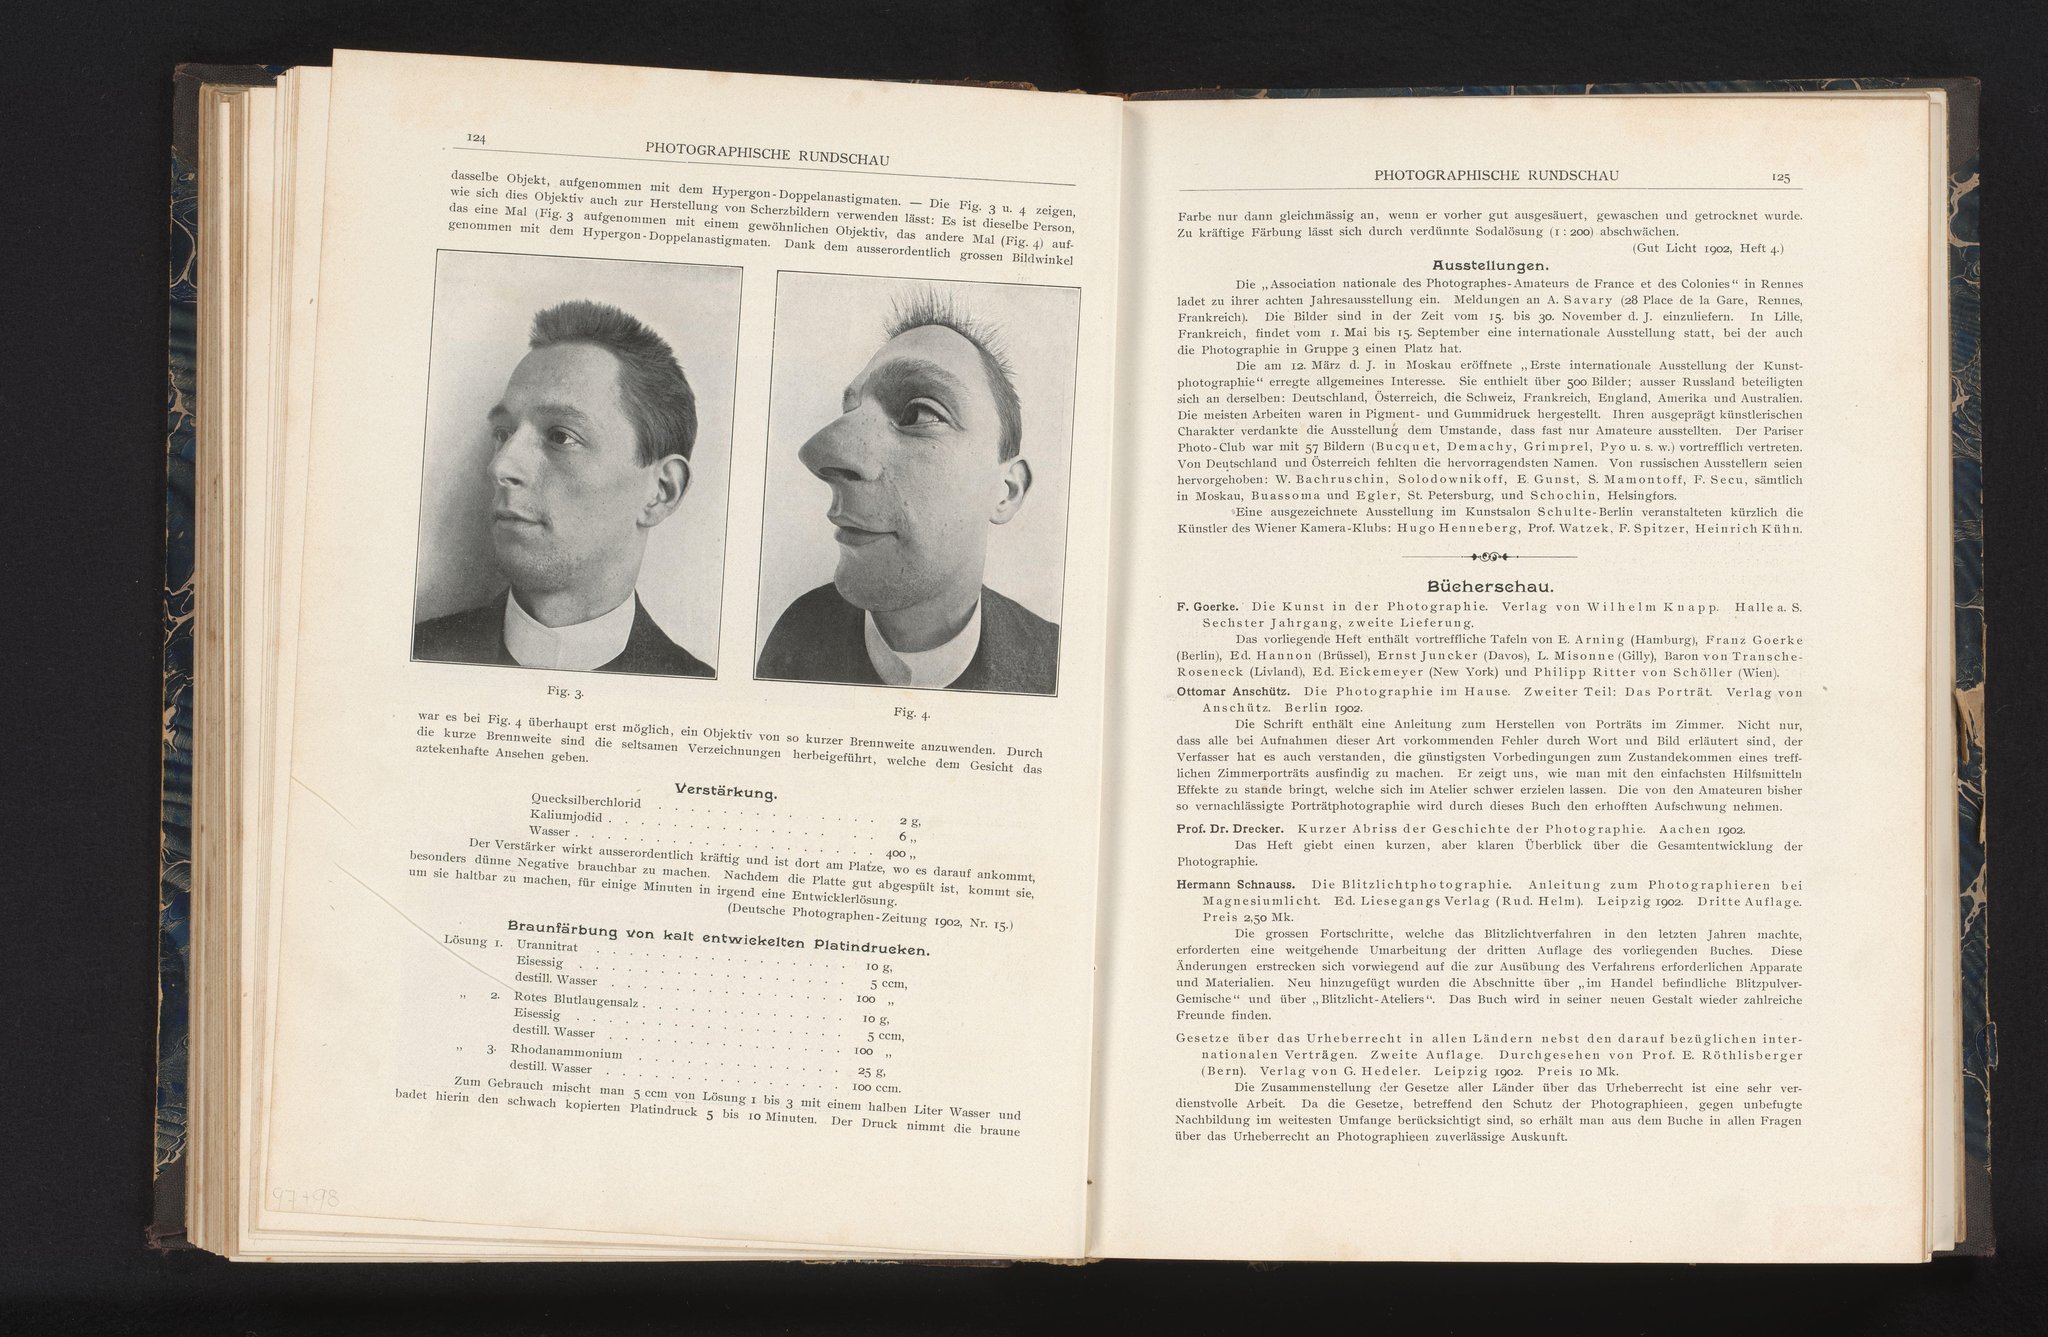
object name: page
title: Vervormd portret van een onbekende man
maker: Anonymous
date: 1897-1902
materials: paper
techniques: autotype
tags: historical persons